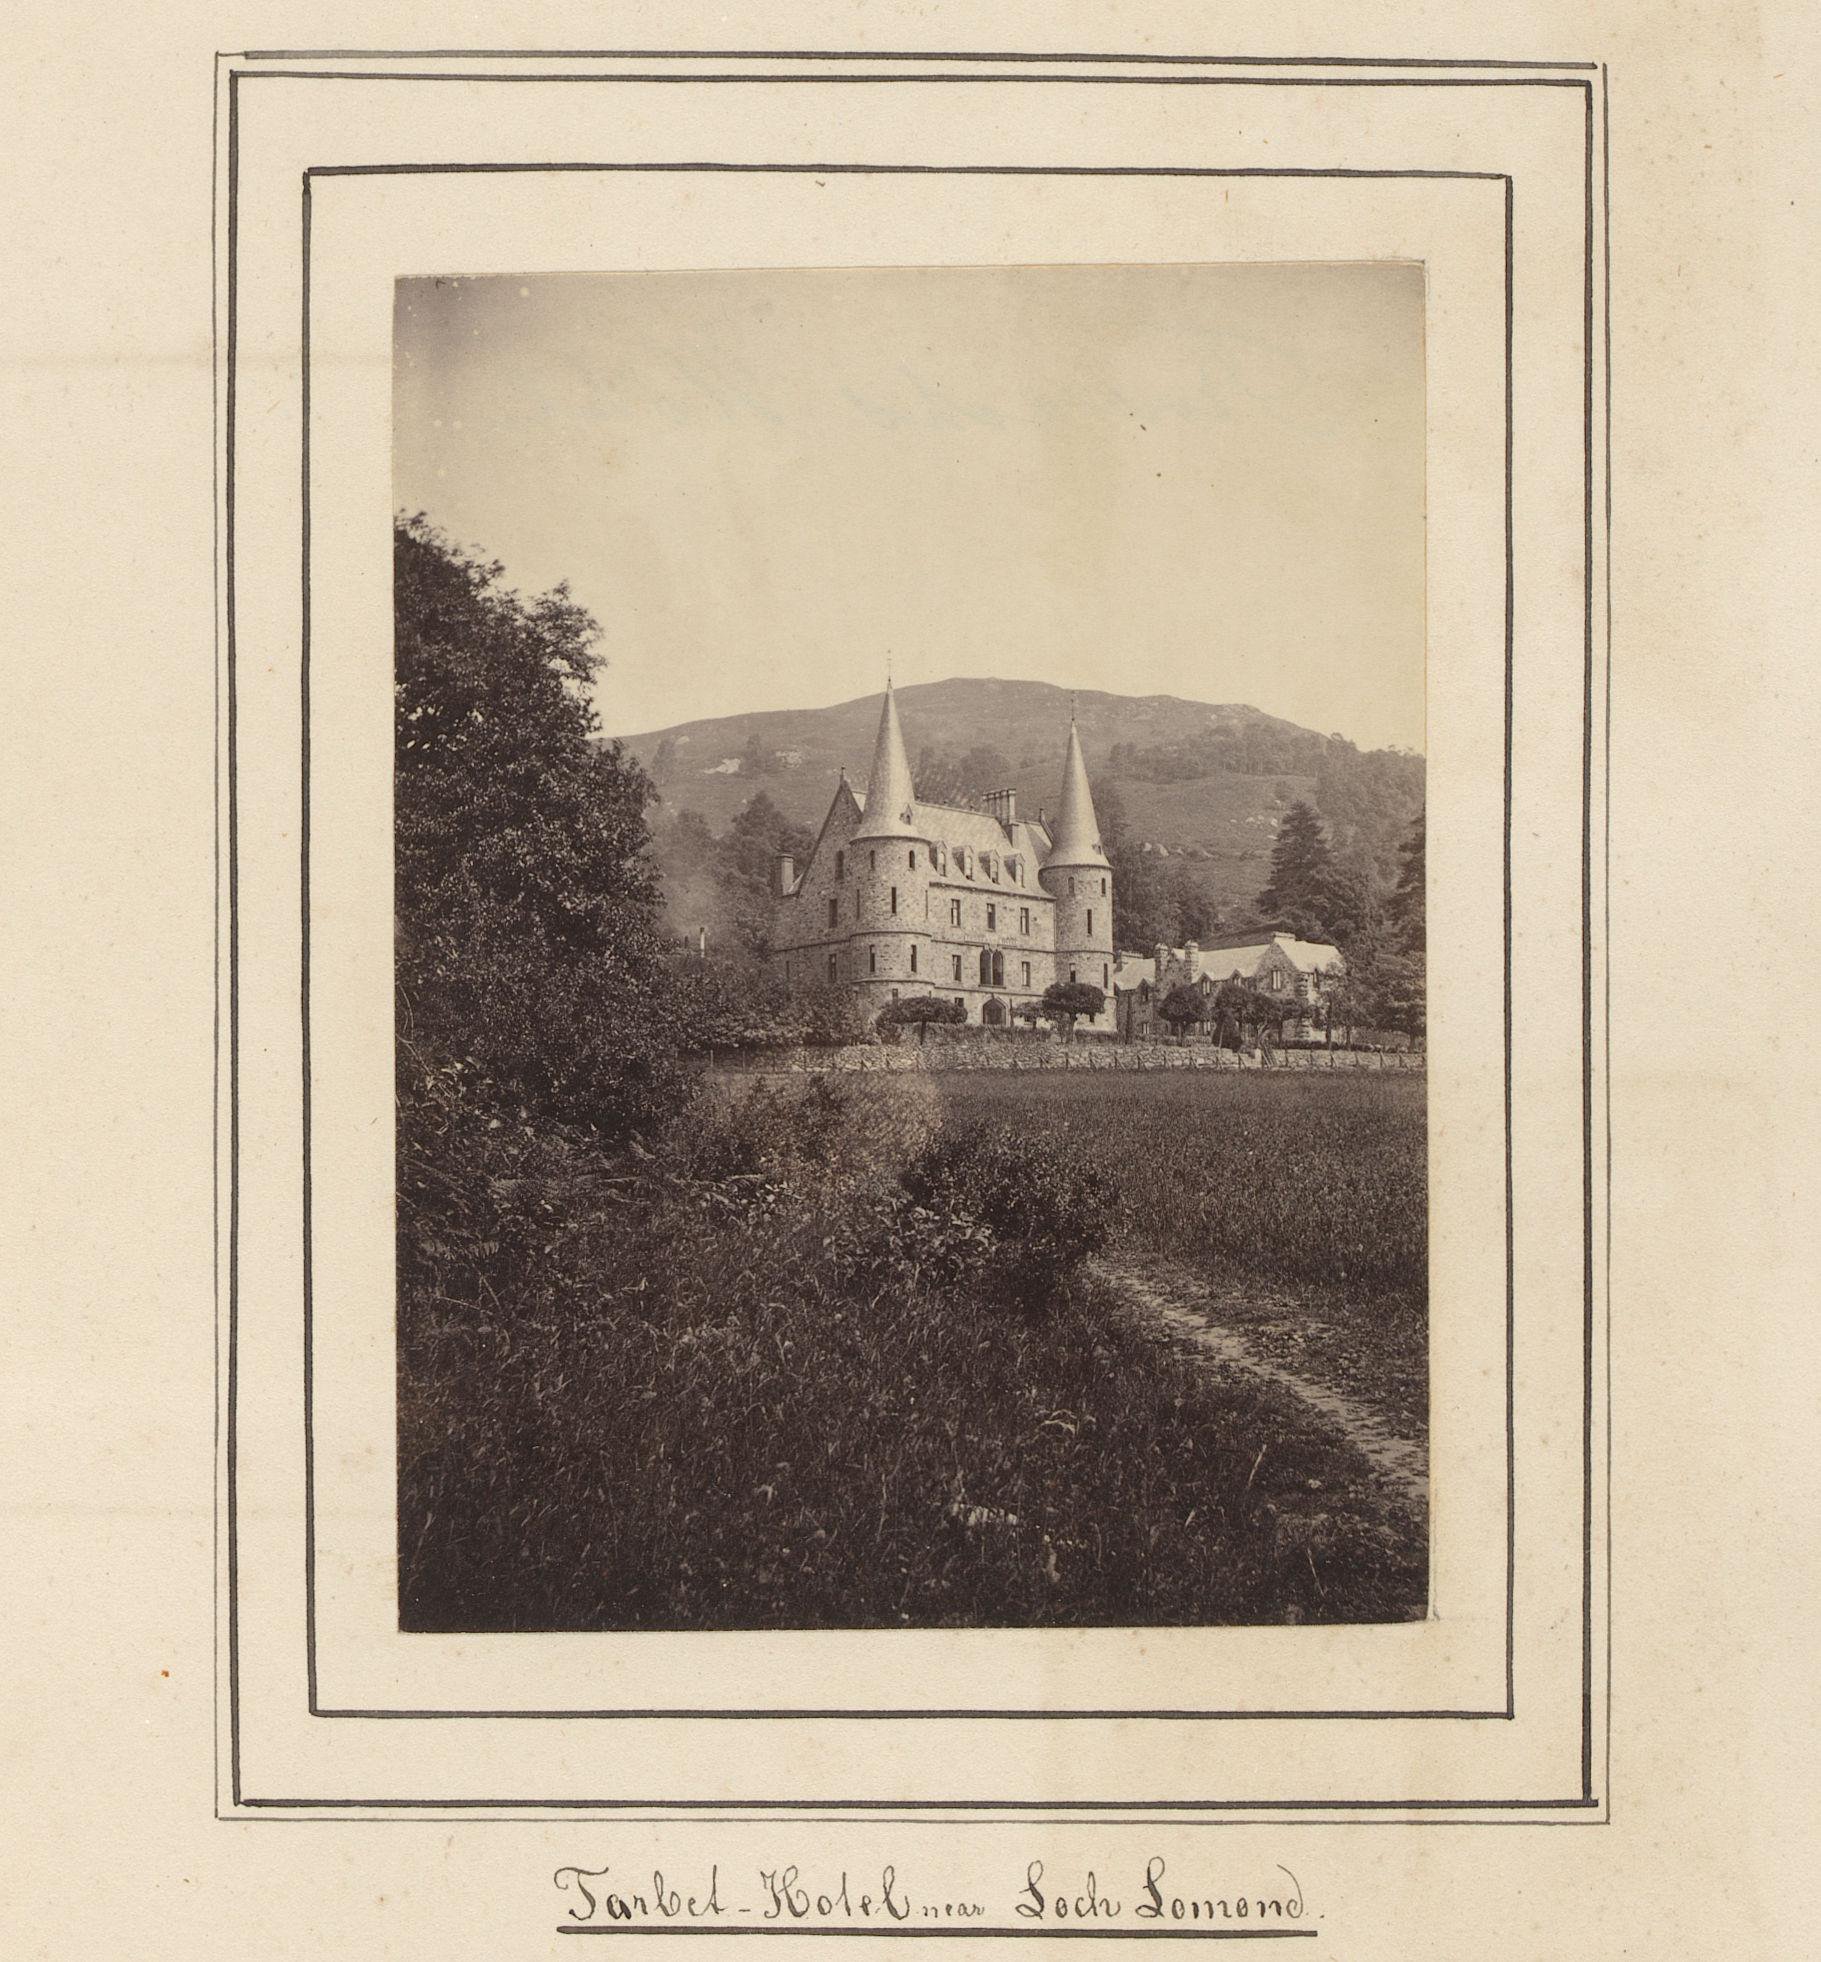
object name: photograph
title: Rotsen aan het water van Loch Lomond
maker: Anonymous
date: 1870-1890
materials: paper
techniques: albumen print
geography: loch lomond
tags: lake, rock-formations